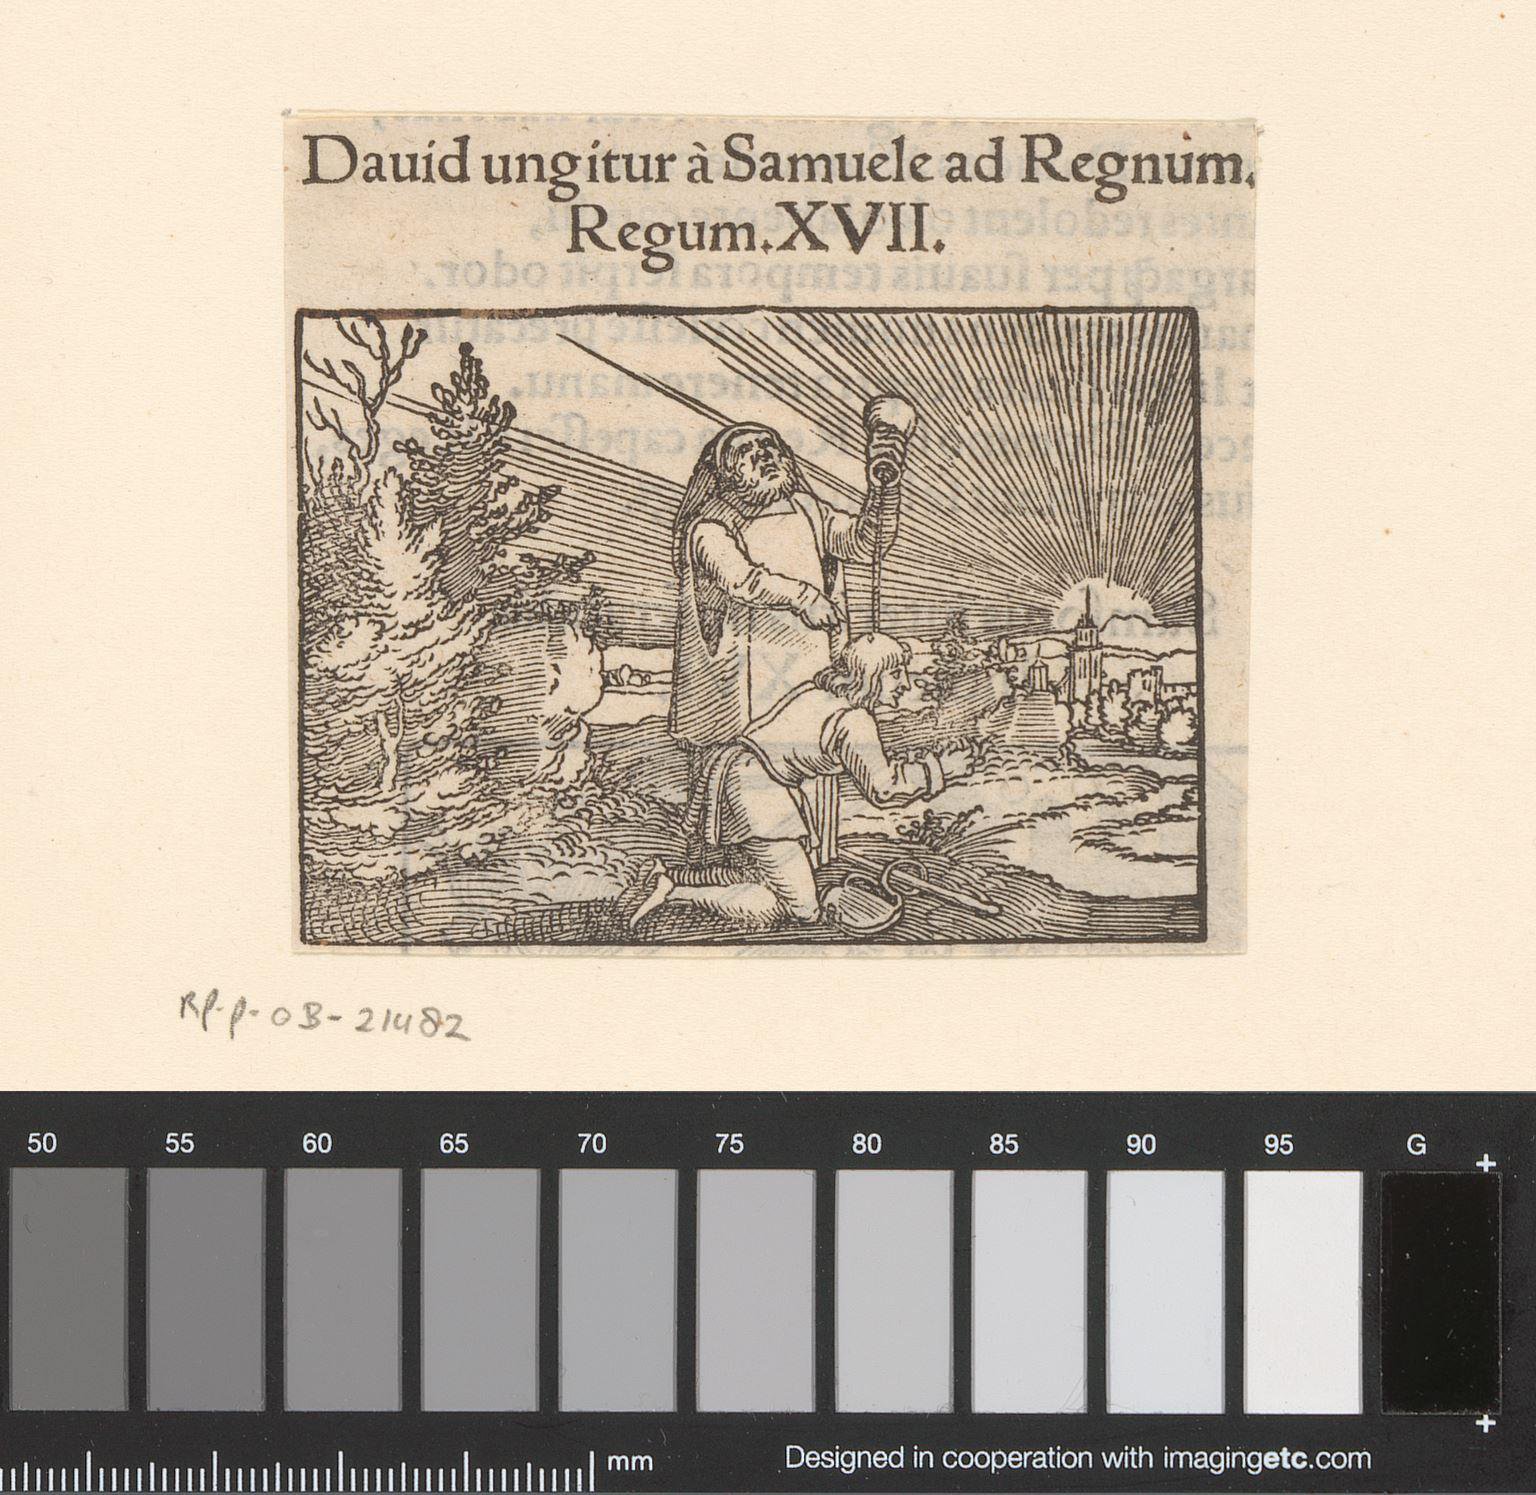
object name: book illustration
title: Dauid ungitur à Samuele ad Regnum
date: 1530-1533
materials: paper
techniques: woodcut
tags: samuel anointing david in the presence of his father jesse and his brothers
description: Prent afkomstig uit: Biblicae historiae. Frankfurt am Main: Egenloph, 1539.